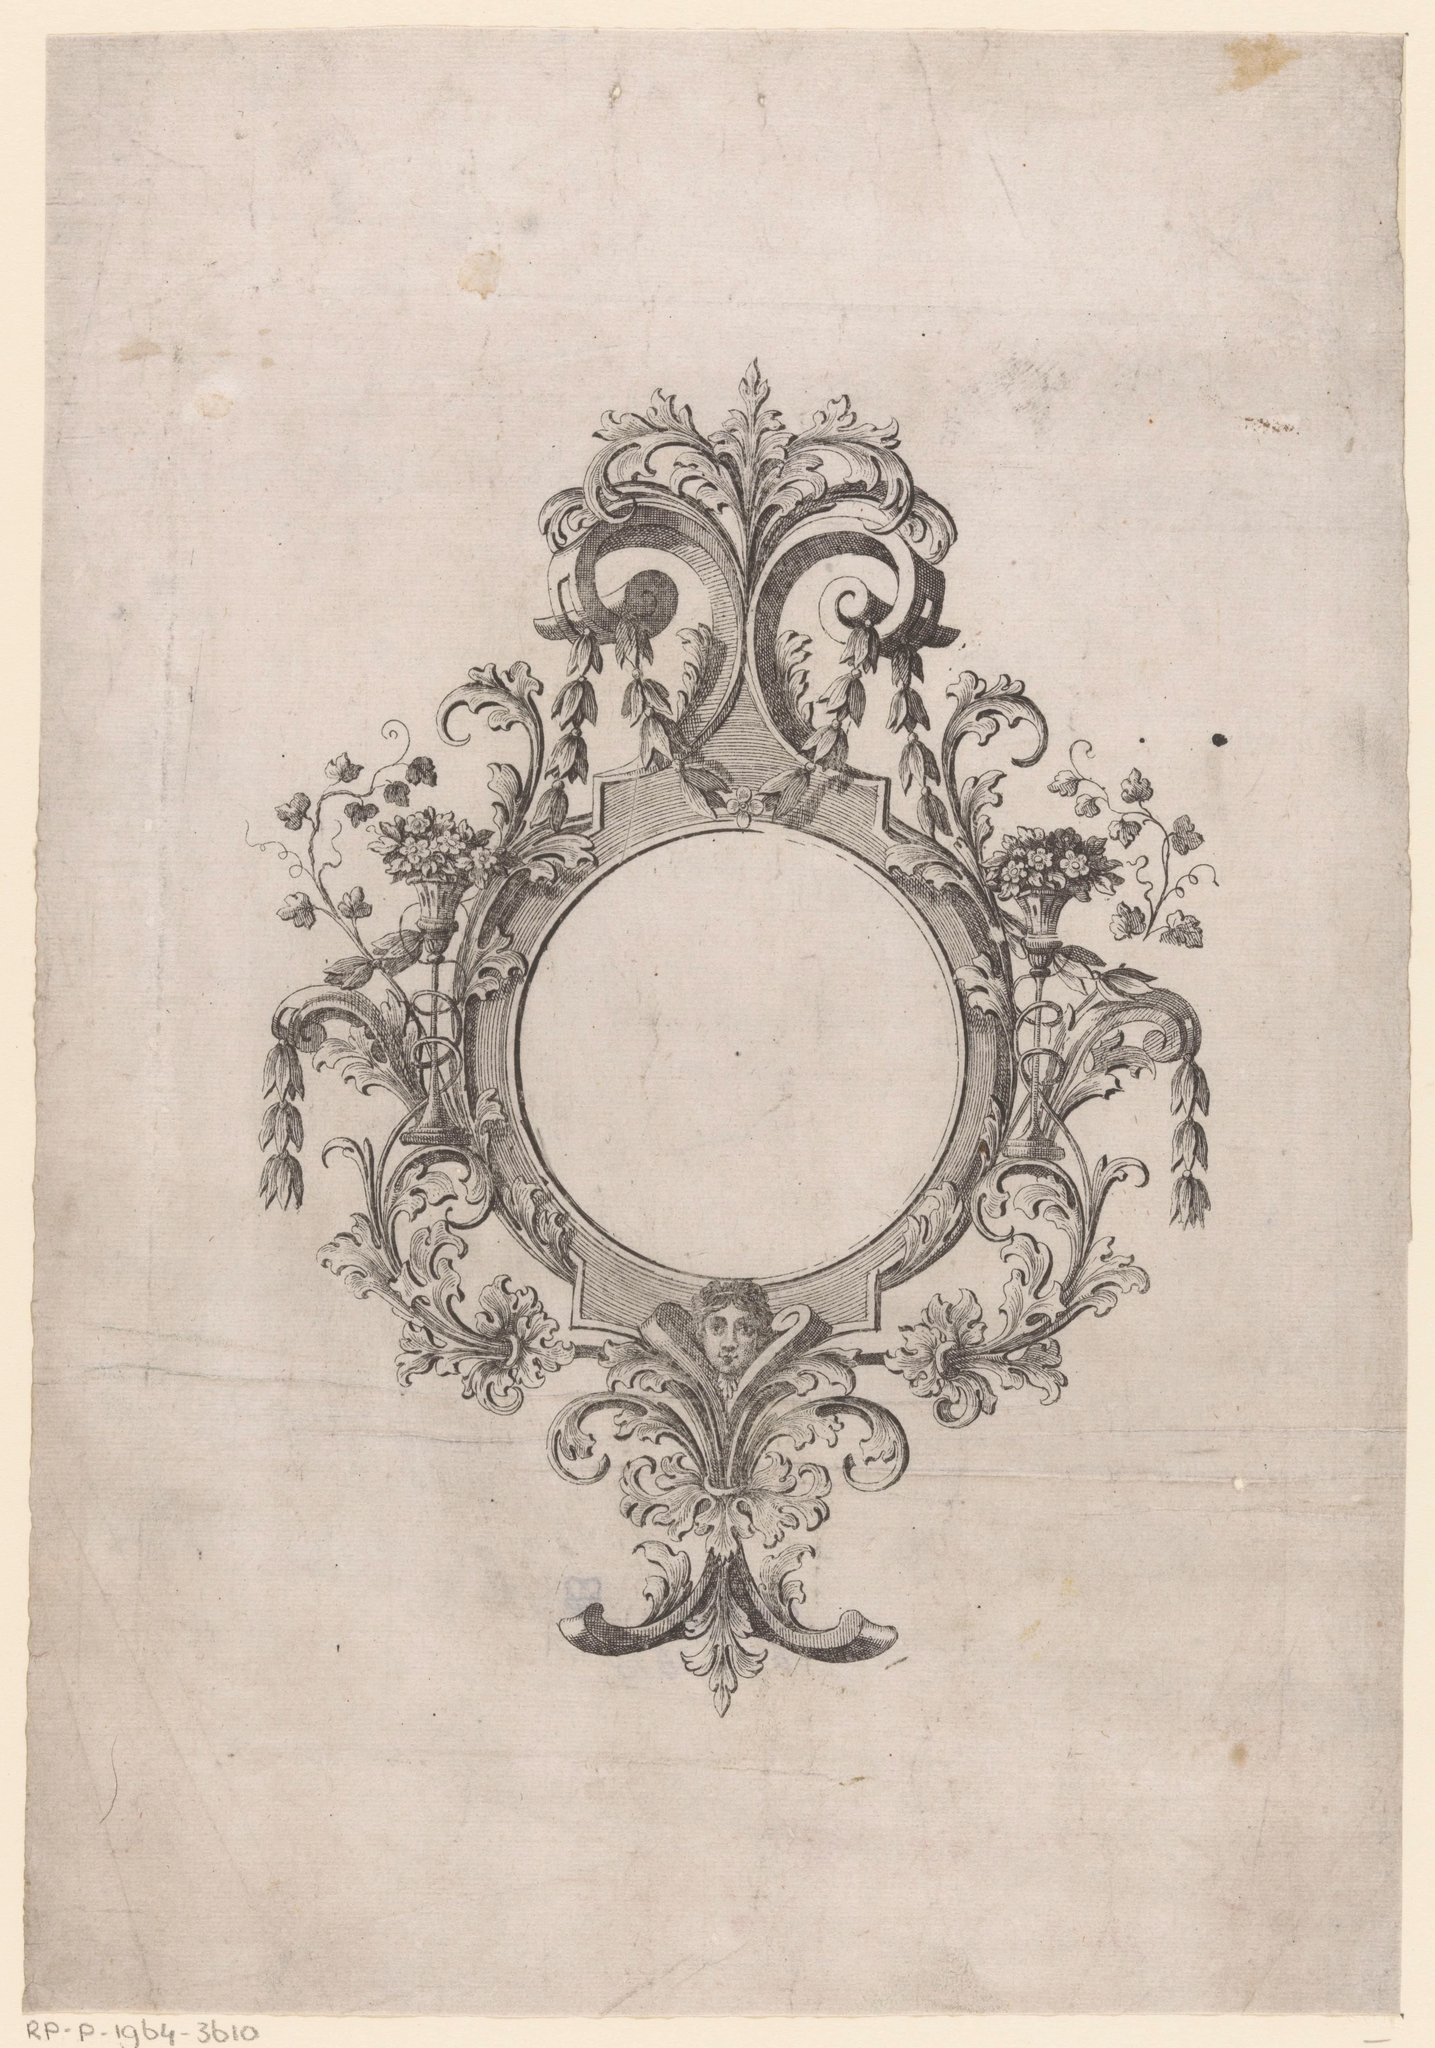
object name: print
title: Ronde omlijsting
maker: Anonymous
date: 1800-1849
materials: paper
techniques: etching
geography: germany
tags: ornament ~ arabesque, ornaments ~ art (+ framing decorations), mask, mascaron ~ ornament, flowers in a vase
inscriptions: collector's mark: Lugt 2228, collector's mark: Lugt 2760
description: Een ronde omlijsting met arabesken, bloemen in vazen en een masker.